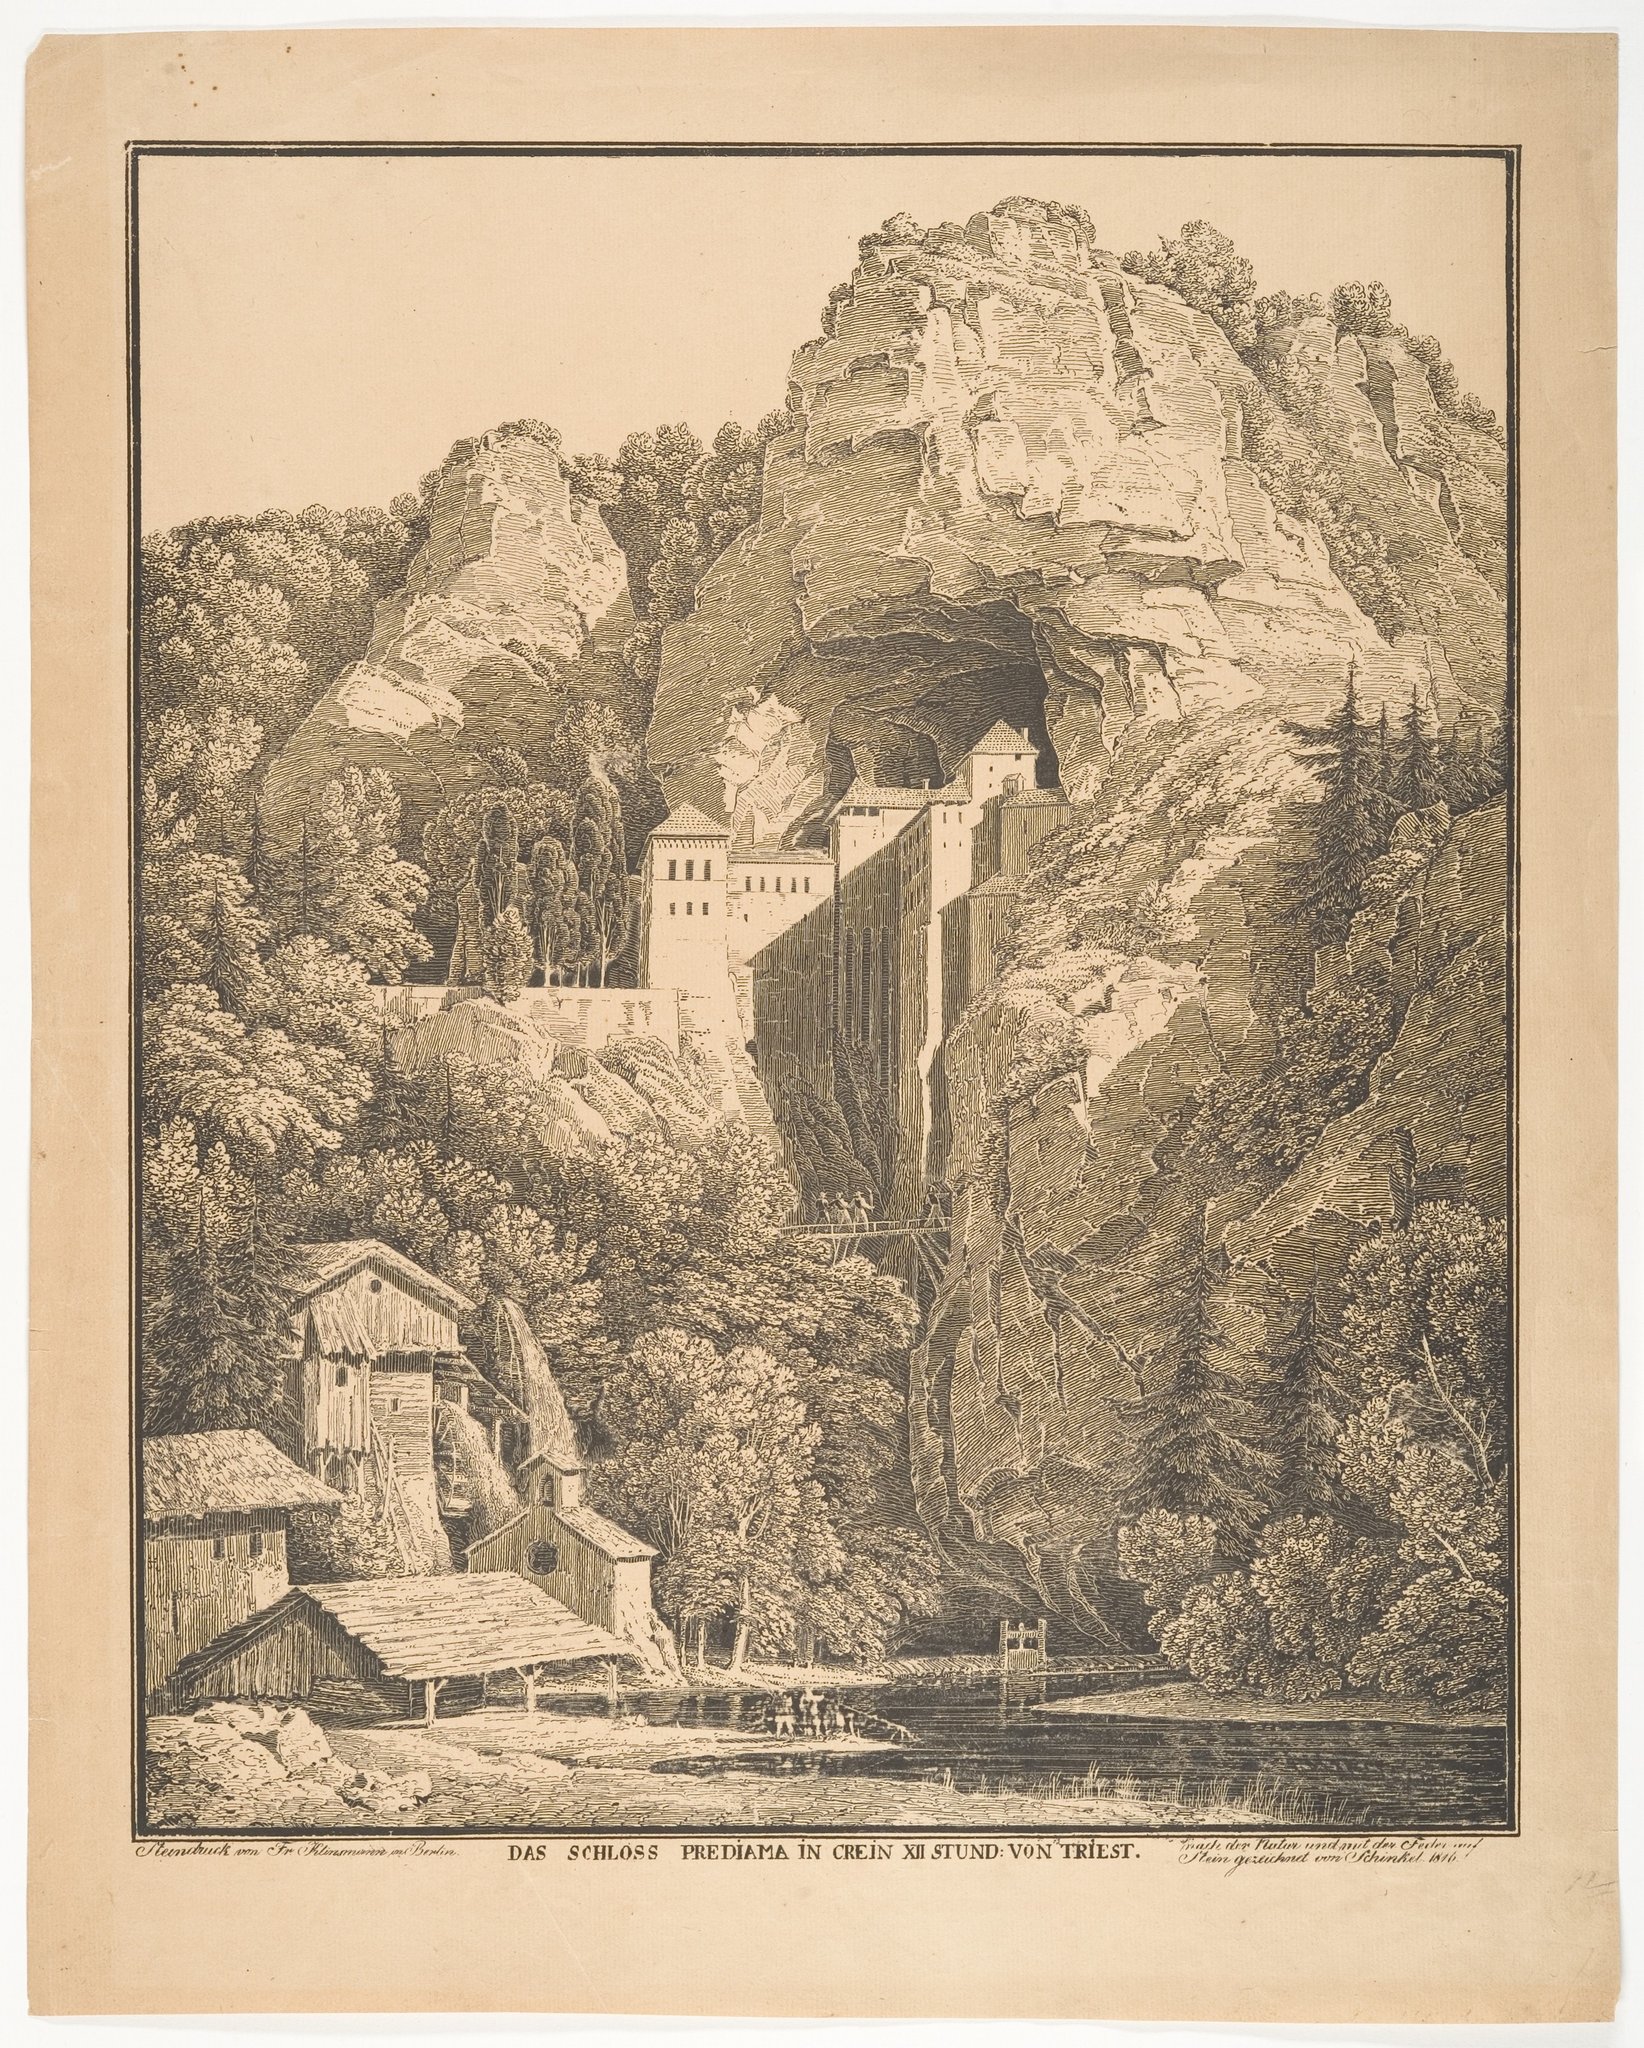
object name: print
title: Das Schloss Prediama in Crein XII Stund: von Triest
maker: karl friedrich schinkel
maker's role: artist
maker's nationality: german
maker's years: 1781-1841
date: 1816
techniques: lithograph, pen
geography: slovenia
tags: castles,mountains